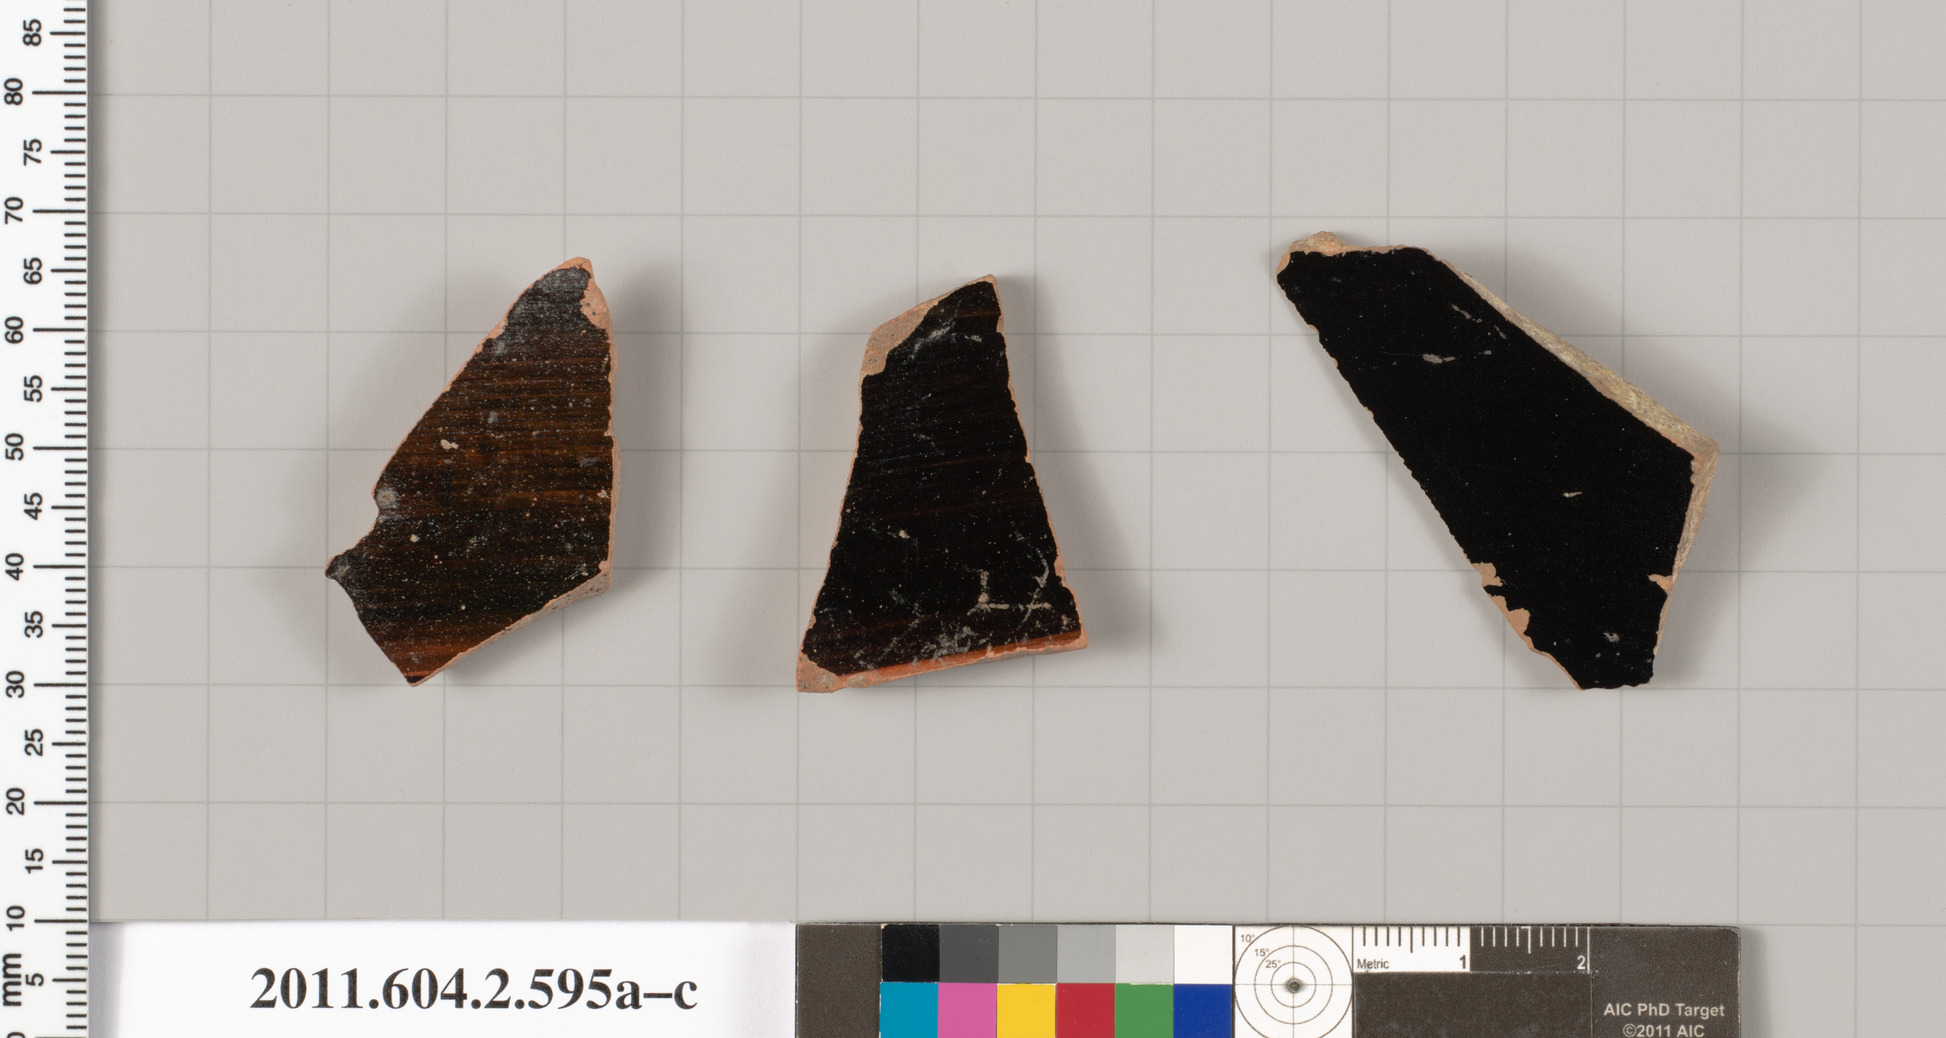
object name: column krater fragment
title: Terracotta fragments of column-kraters (bowls for mixing wine and water)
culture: greek, attic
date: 470-440 BCE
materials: terracotta